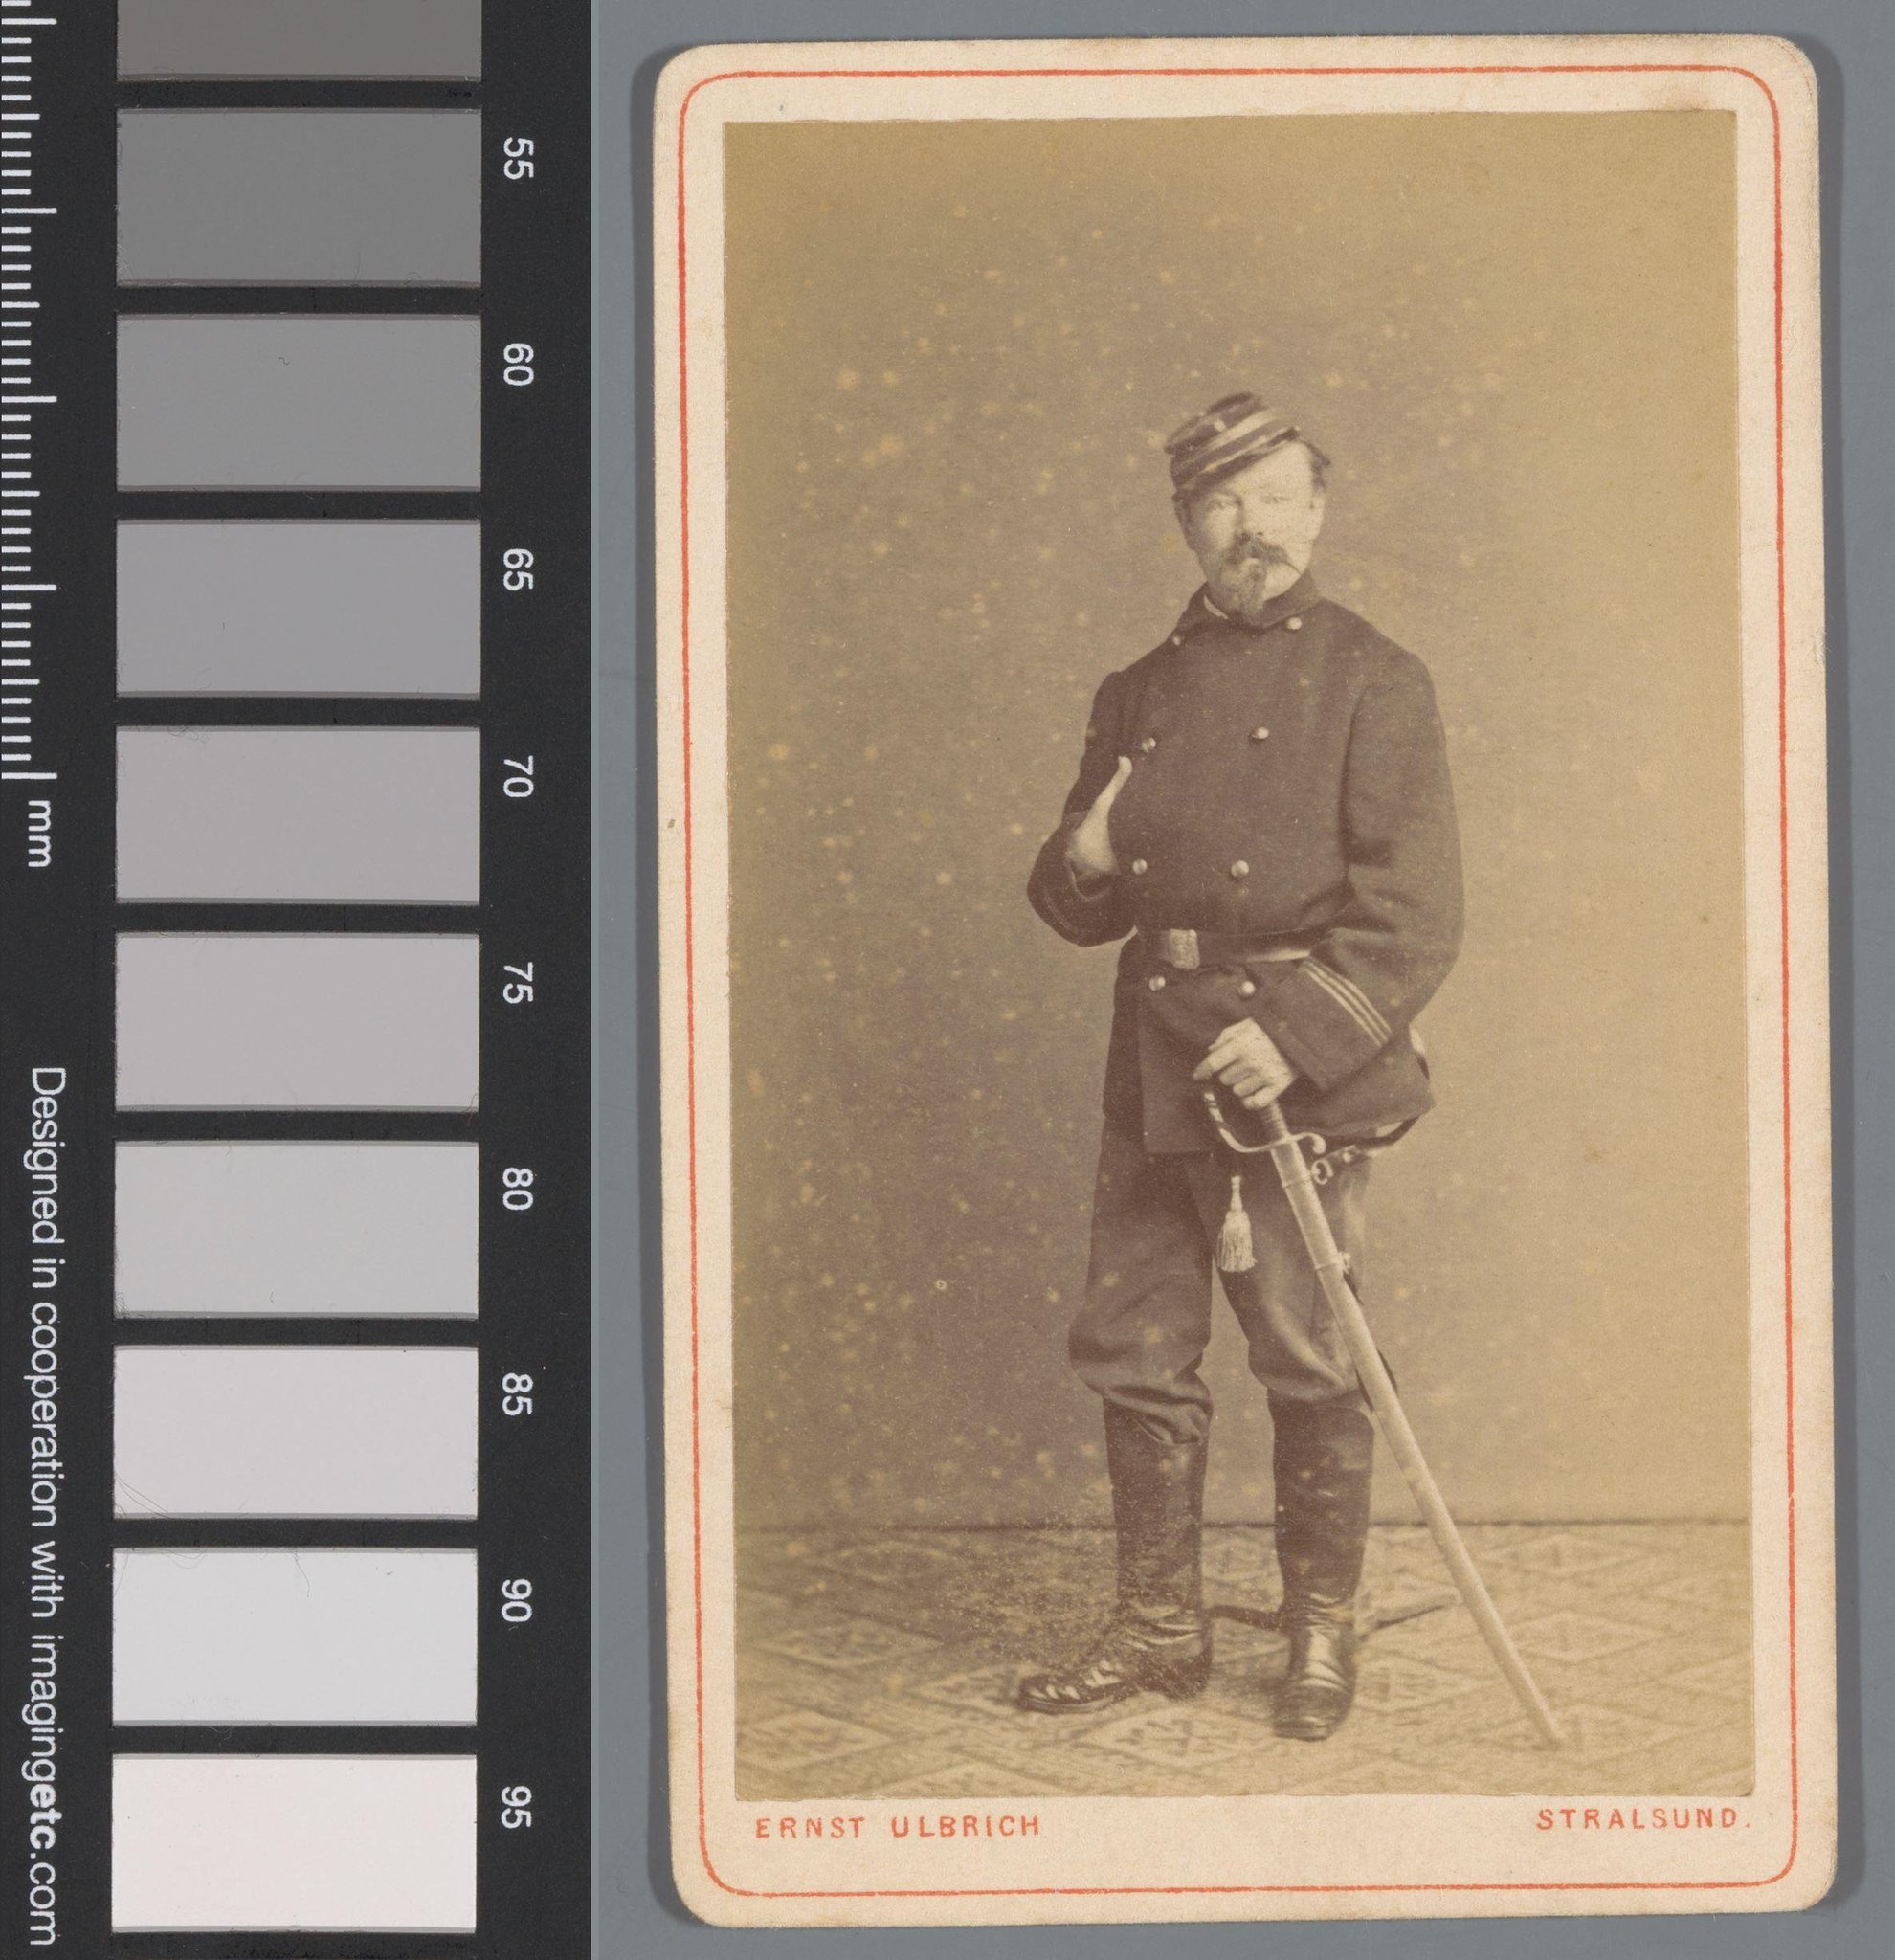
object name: photograph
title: Portret van een onbekende man in uniform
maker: ernst ulbrich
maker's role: fotograaf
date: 1869-1895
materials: cardboard, paper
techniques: albumen print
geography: stralsund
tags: adult man, anonymous historical person portrayed, (military) uniforms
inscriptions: inscription: ‘Ernst Ulbrich Stralsund.’